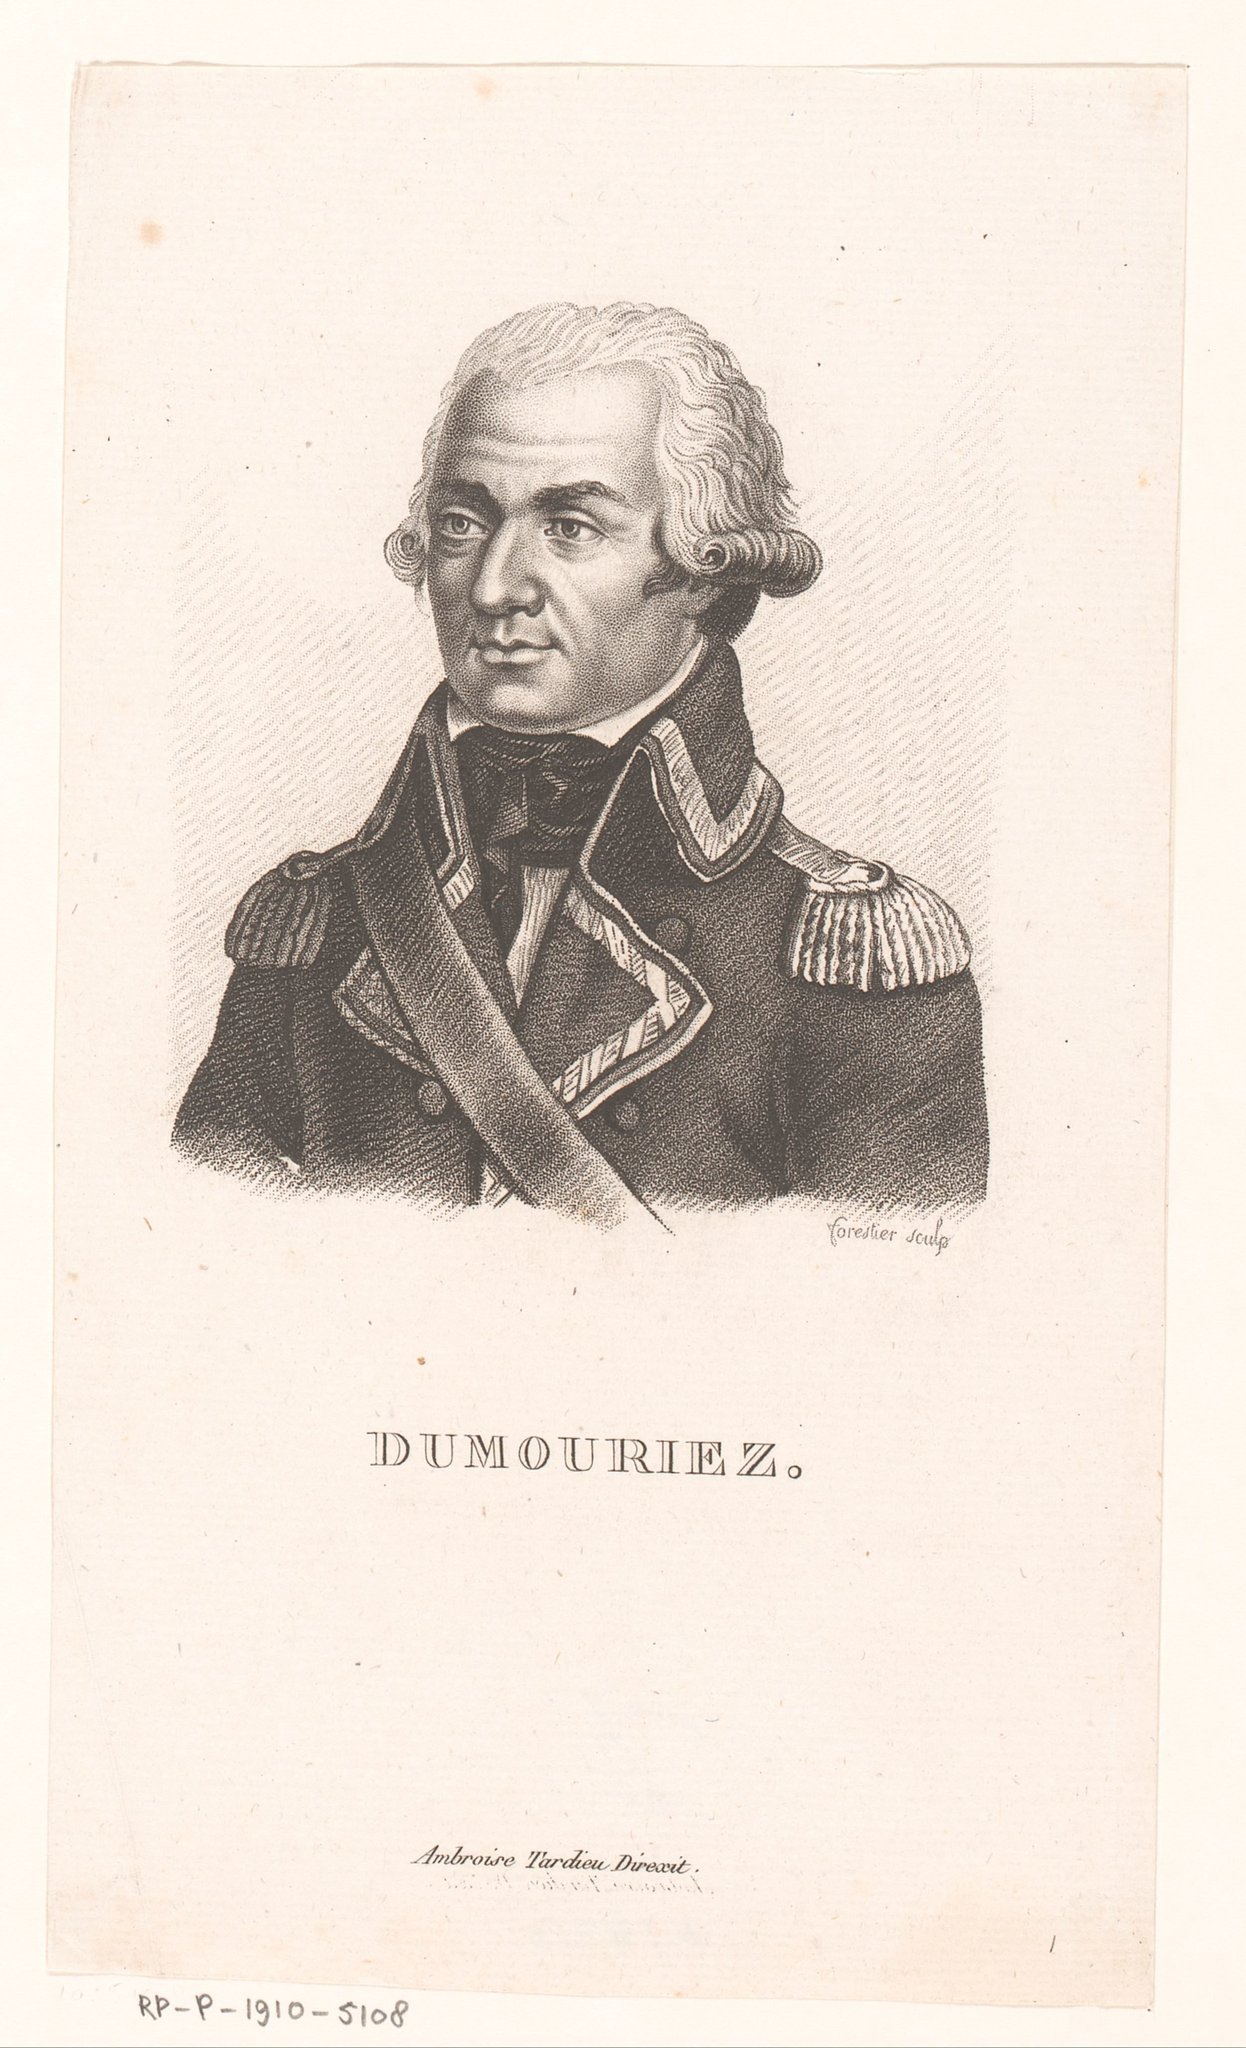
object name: book illustration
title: Portret van Charles-François Dumouriez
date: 1818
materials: paper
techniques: etching, roulette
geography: paris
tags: commander-in-chief, general, marshal, historical persons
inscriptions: collector's mark: Lugt 2228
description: Mogelijk prent uit: Tardieu, Ambroise. Portraits des généraux français, faisant suite aux "Victoires et conquêtes des Français". Parijs: Panckoucke, Charles Louis Fleury, ca. 1818.